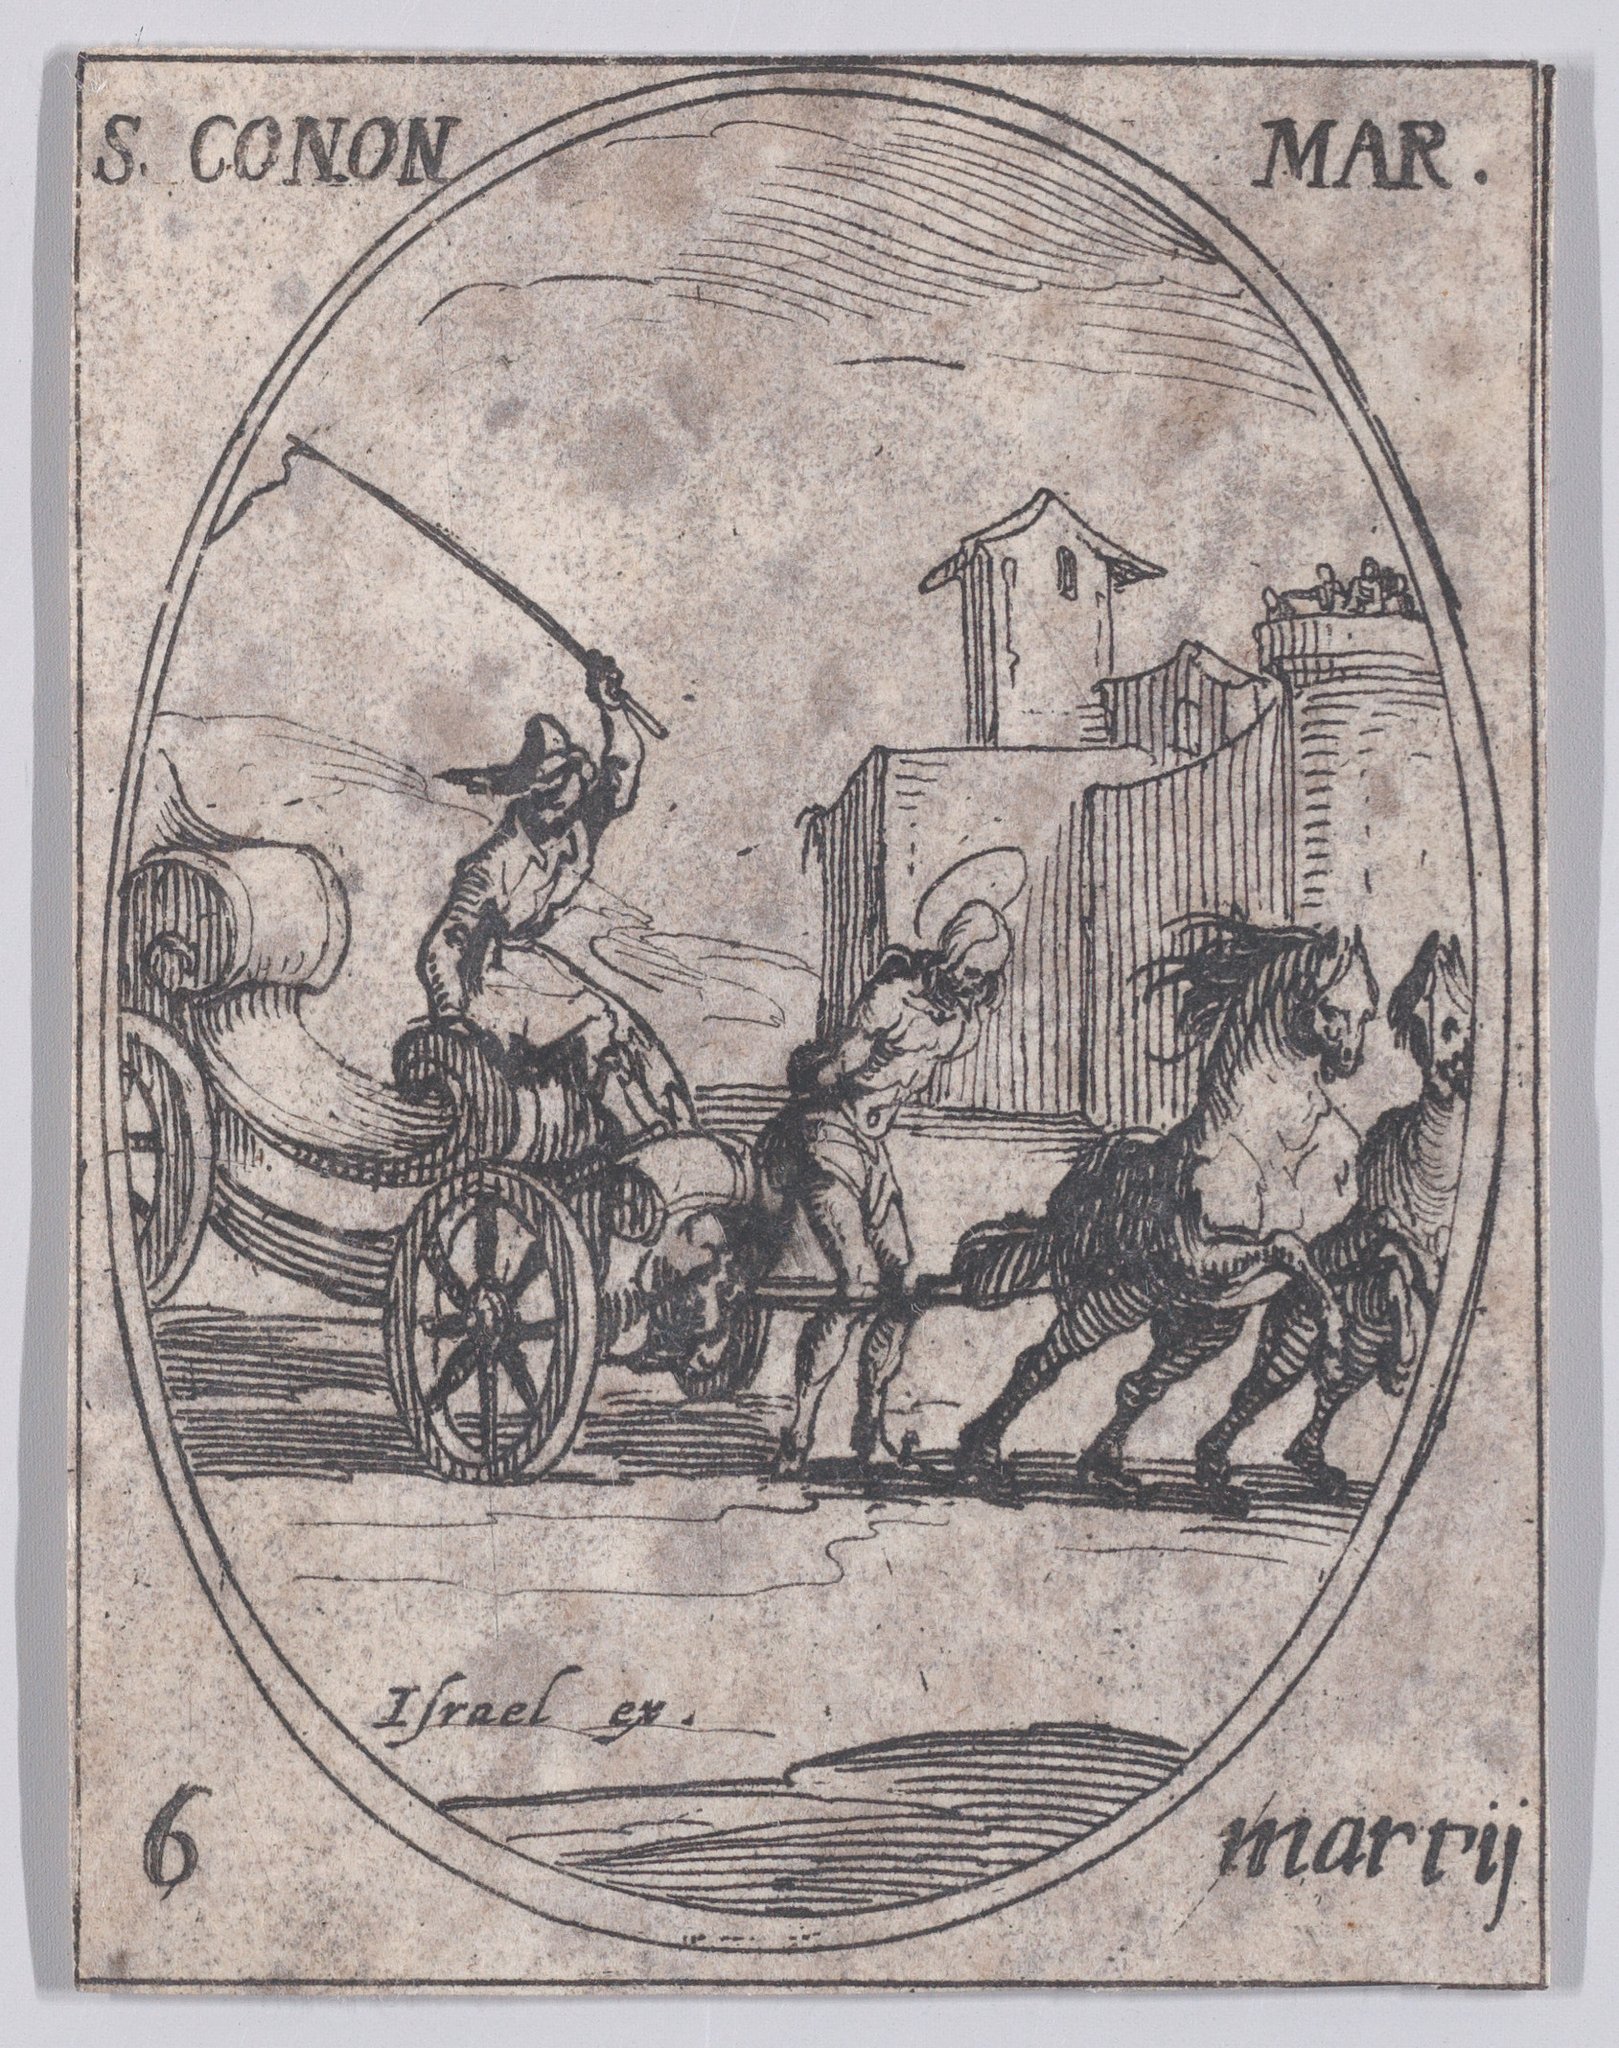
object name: print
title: St. Conon, Martyr, March 6th, from "Les Images De Tous Les Saincts et Saintes de L'Année" (Images of All of the Saints and Religious Events of the Year)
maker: jacques callot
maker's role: artist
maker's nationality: french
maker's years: 1592-1635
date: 1636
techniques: etching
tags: men,horses,saints,carriages